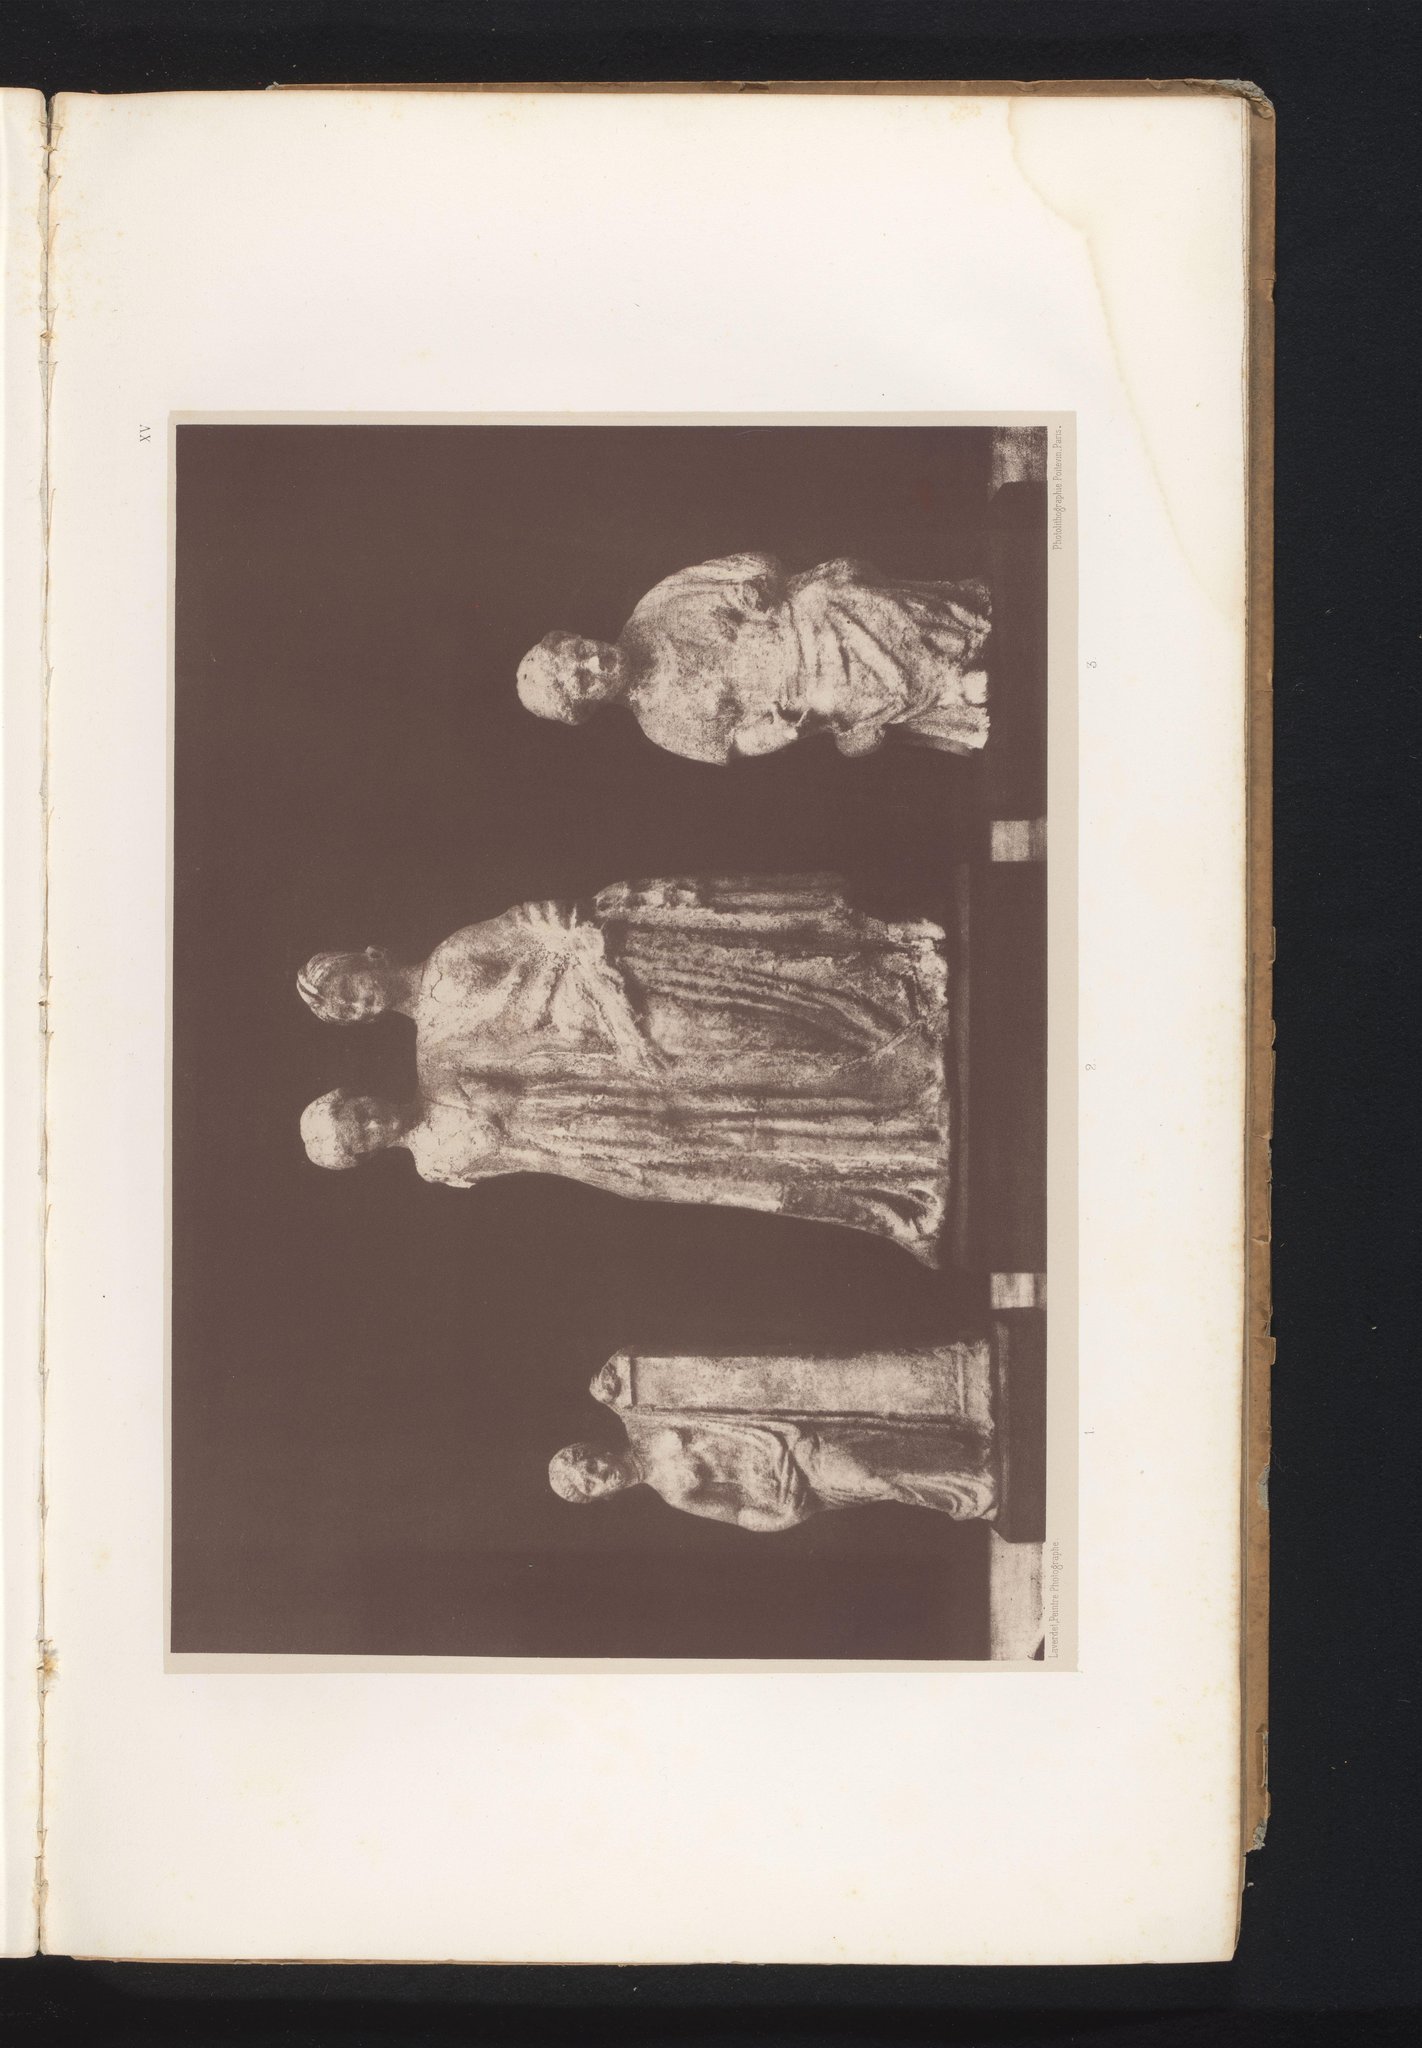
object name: page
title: Drie terracotta sculpturen van een vrouw, twee vrouwen en een oude vrouw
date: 1852-1857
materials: paper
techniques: photolithography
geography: paris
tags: piece of sculpture, reproduction of a piece of sculpture (+ clay, sand, etc. ~ arts), old woman, adult woman (+ two persons)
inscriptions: number: ‘1. 2. 3.’, number: ‘XV.’